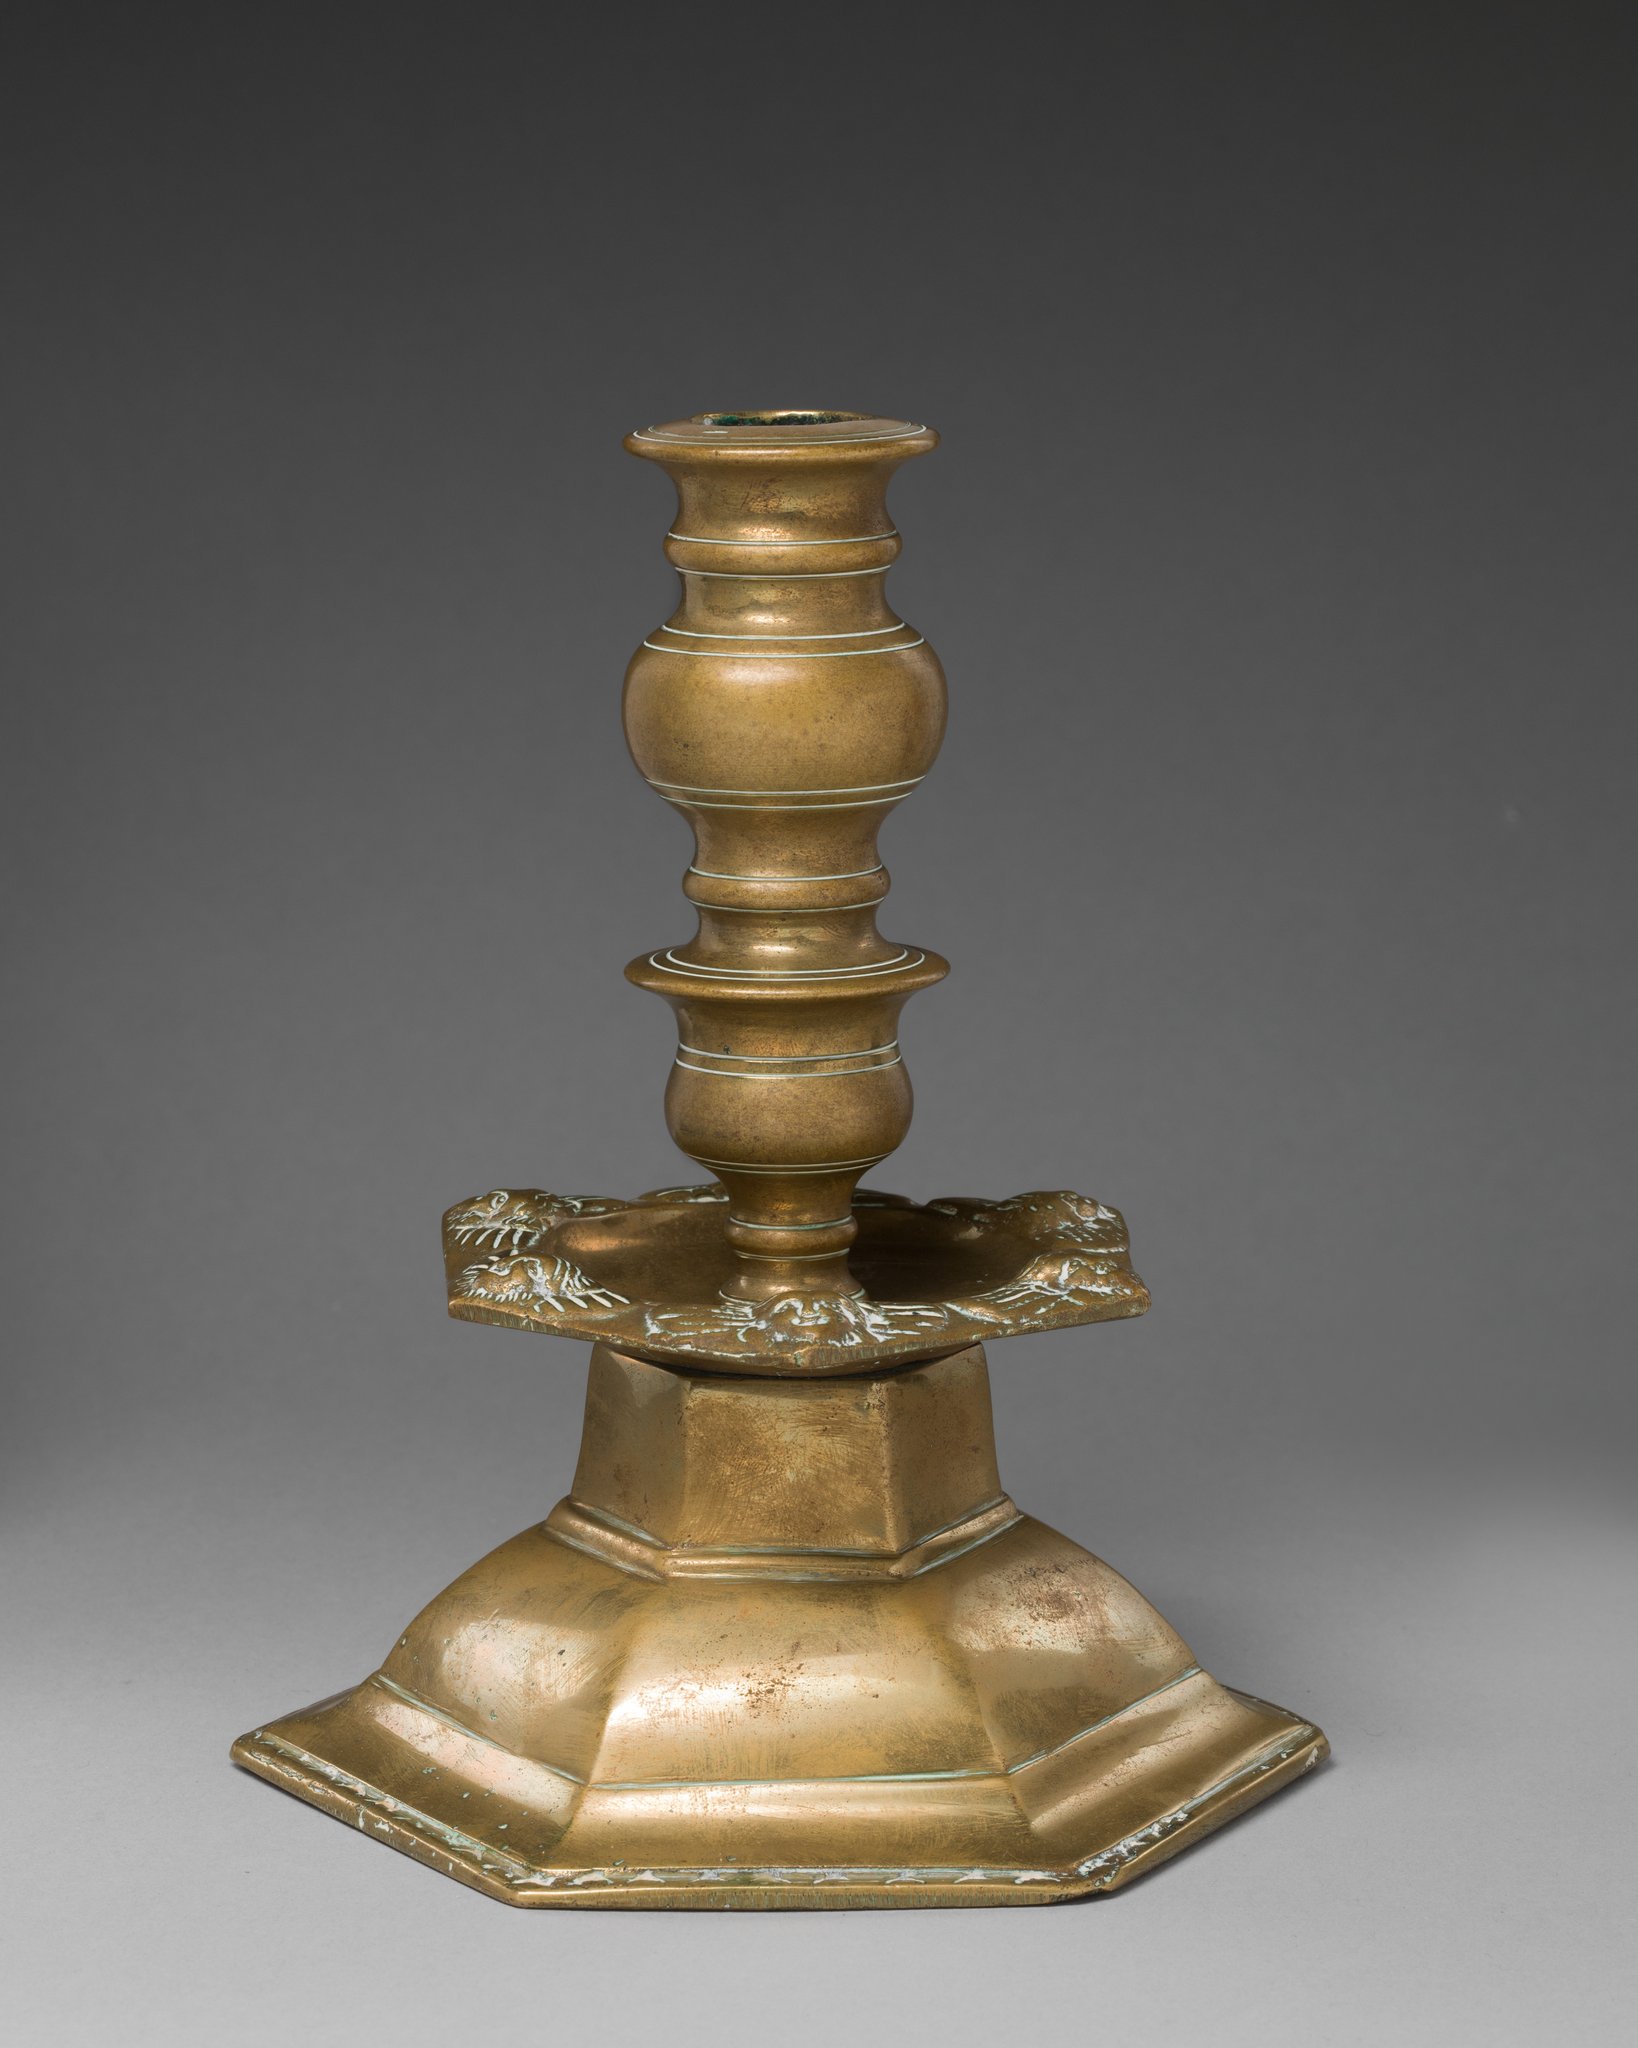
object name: candlestick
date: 1801-1900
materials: brass